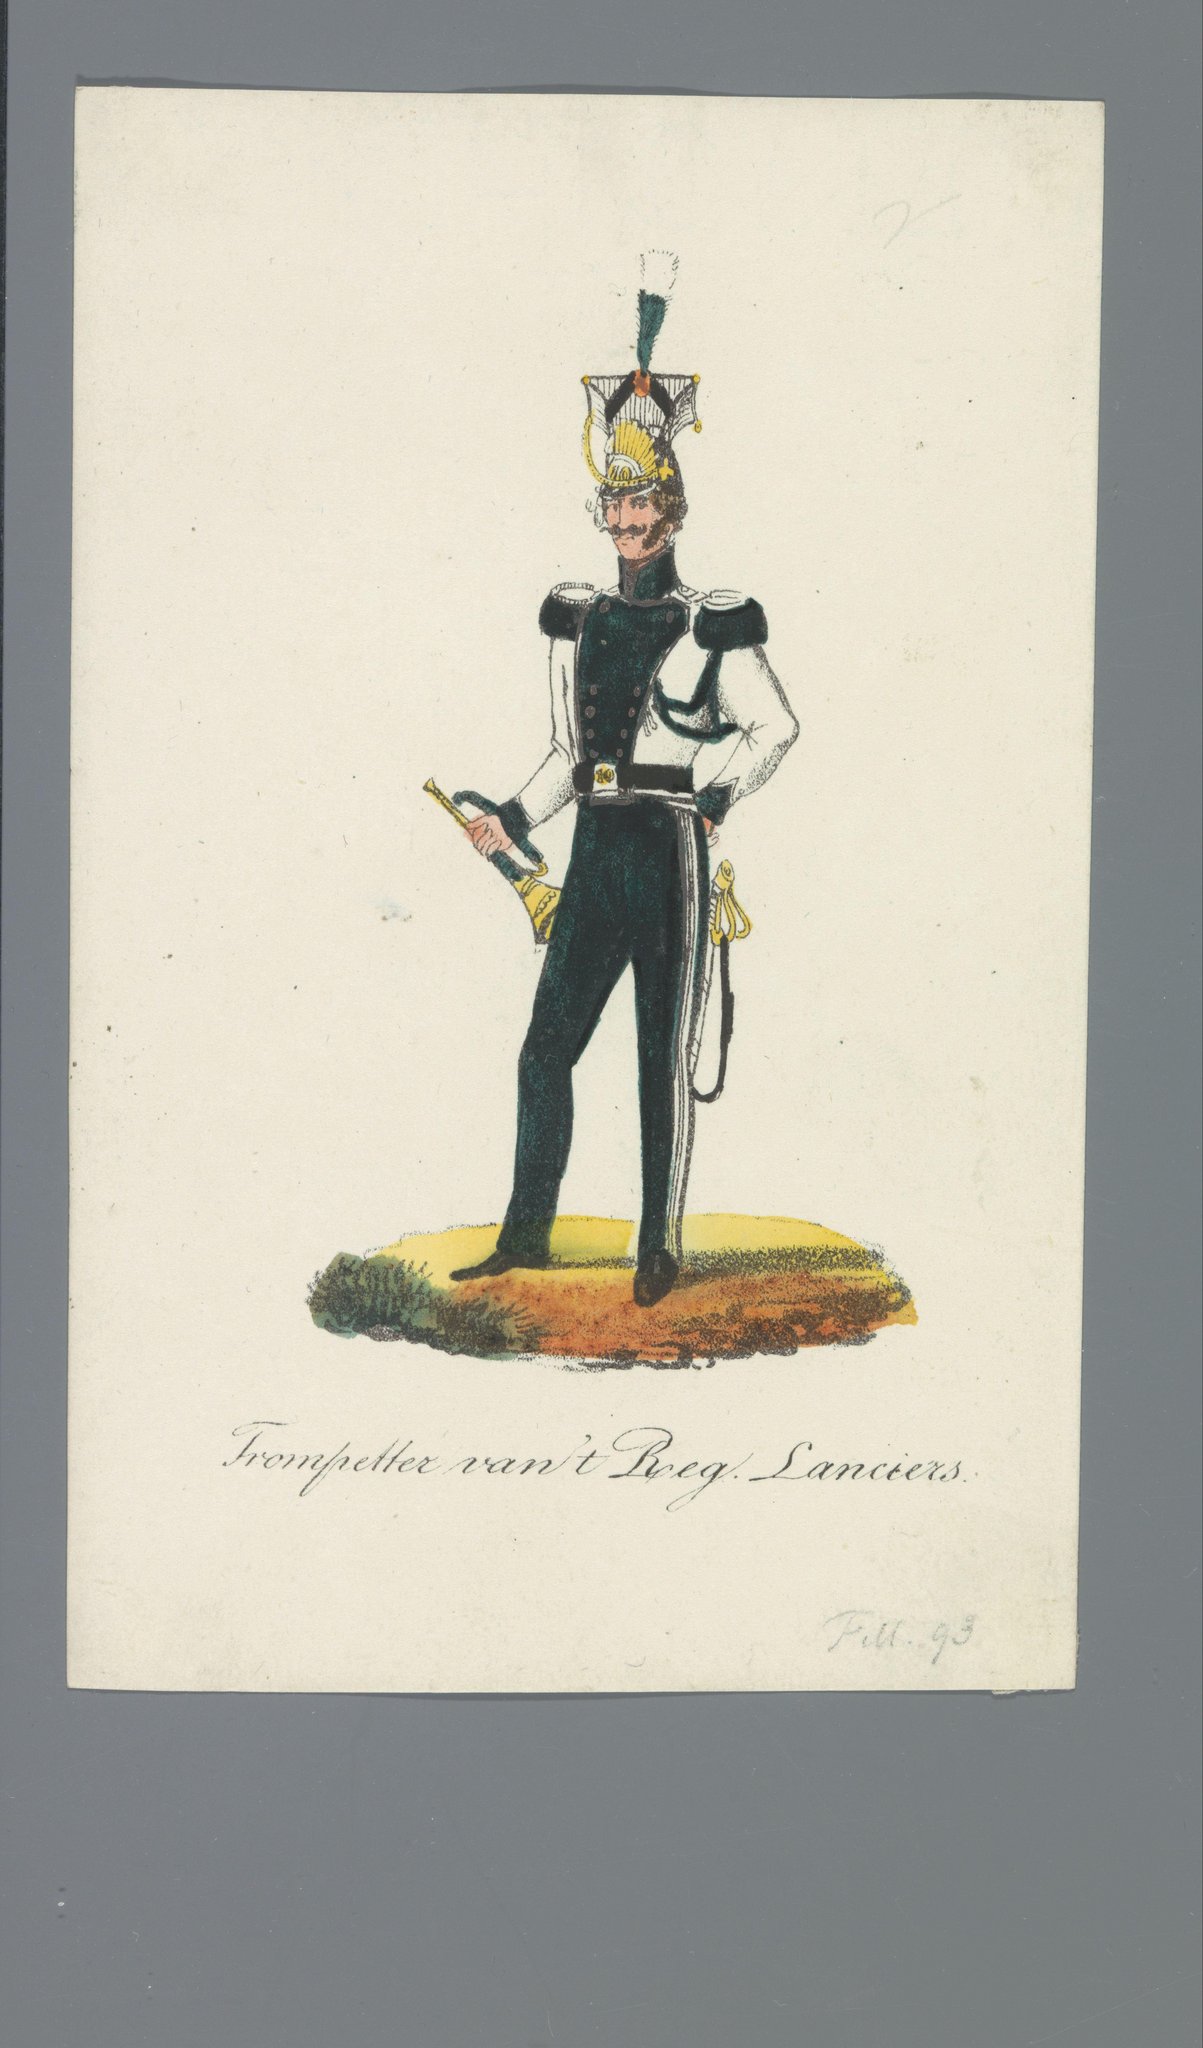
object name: costume print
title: Nederlandse militaire uniformen in de jaren 1830-1832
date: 1835-1850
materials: paper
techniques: hand coloring, lithograph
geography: utrecht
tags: (military) uniforms, clothes, costume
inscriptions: collector's mark: Lugt 2228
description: Een trompetter van het 10e Regiment Lansiers, te voet. Onderdeel van een serie van 157 losse bladen met Nederlandse militaire uniformen in de jaren 1830-1832.